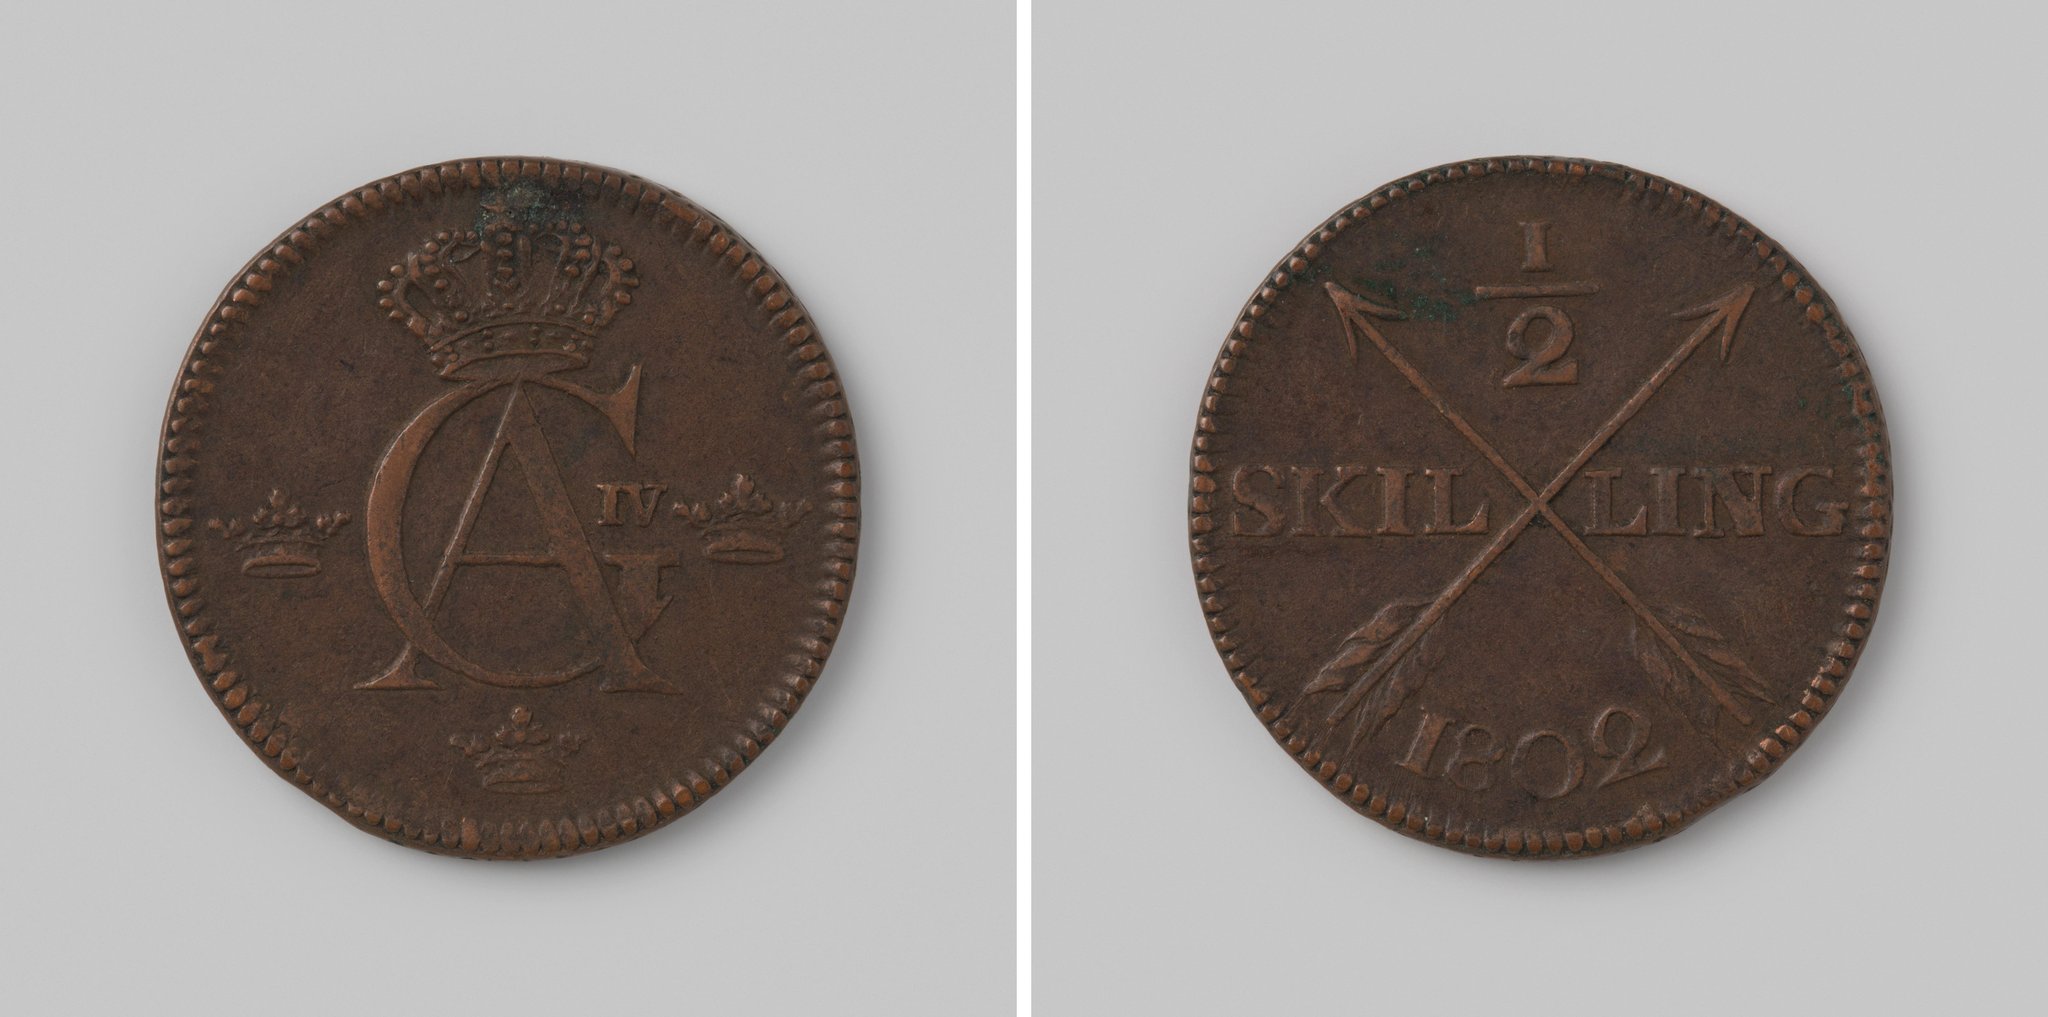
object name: coin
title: ½ skilling uit Zweden van Gustaf IV Adolf, 1802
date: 1802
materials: copper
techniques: striking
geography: slot rörstrand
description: Koperen munt. Voorzijde: tussen drie kronen monogram van de vorst, waarboven koningskroon. Keerzijde: twee gekruiste pijlen. Waarde-aanduiding in het veld. Jaartal onderaan. Kartelrand.